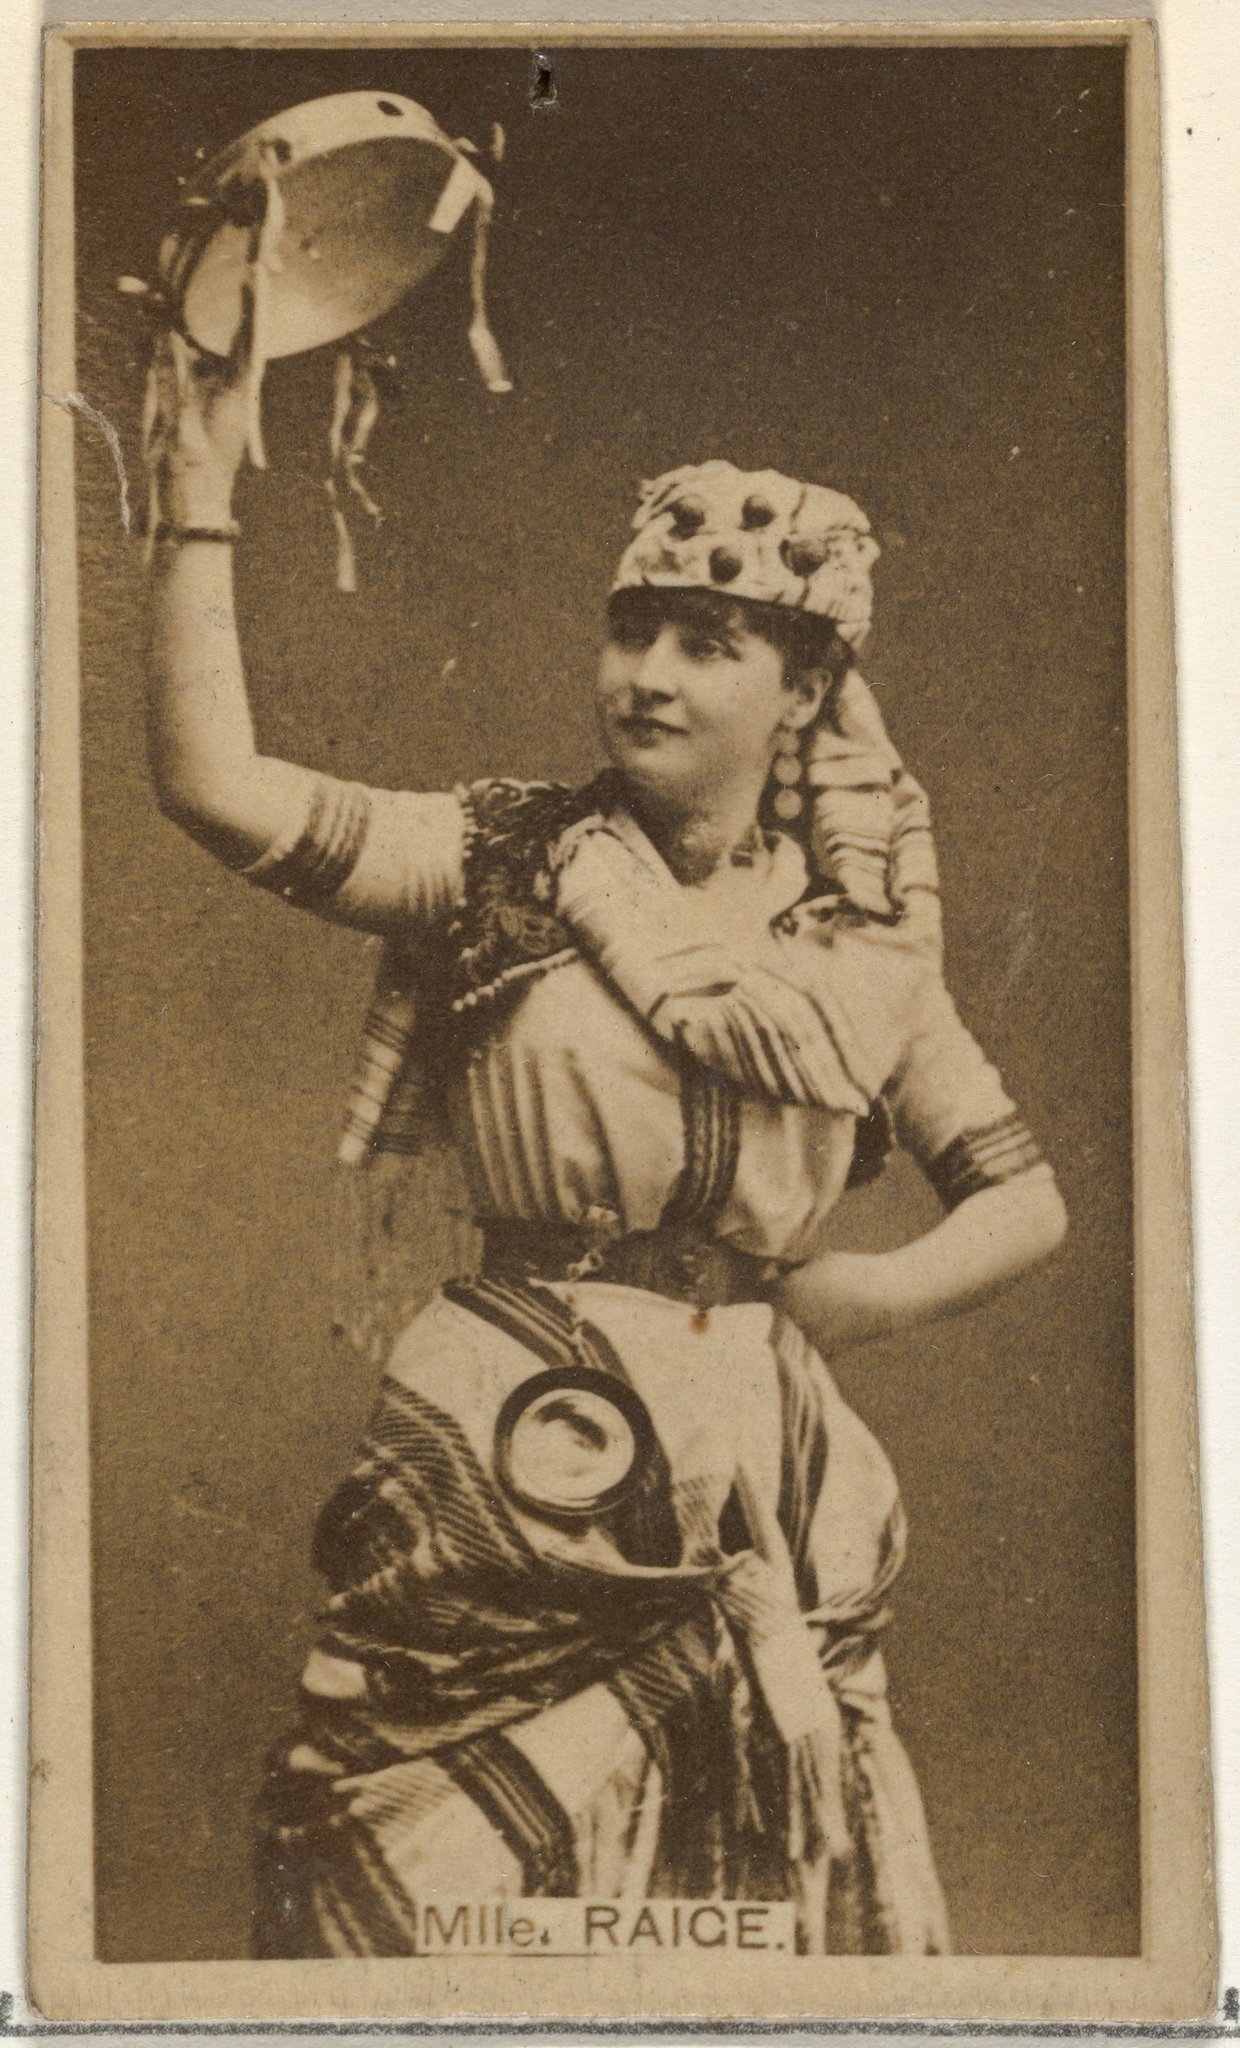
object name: photograph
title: Mlle. Raige, from the Actors and Actresses series (N145-8) issued by Duke Sons & Co. to promote Duke Cigarettes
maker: w. duke, sons & co.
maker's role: publisher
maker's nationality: american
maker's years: 1870-1920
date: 1891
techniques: albumen silver print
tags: portraits,women,actresses